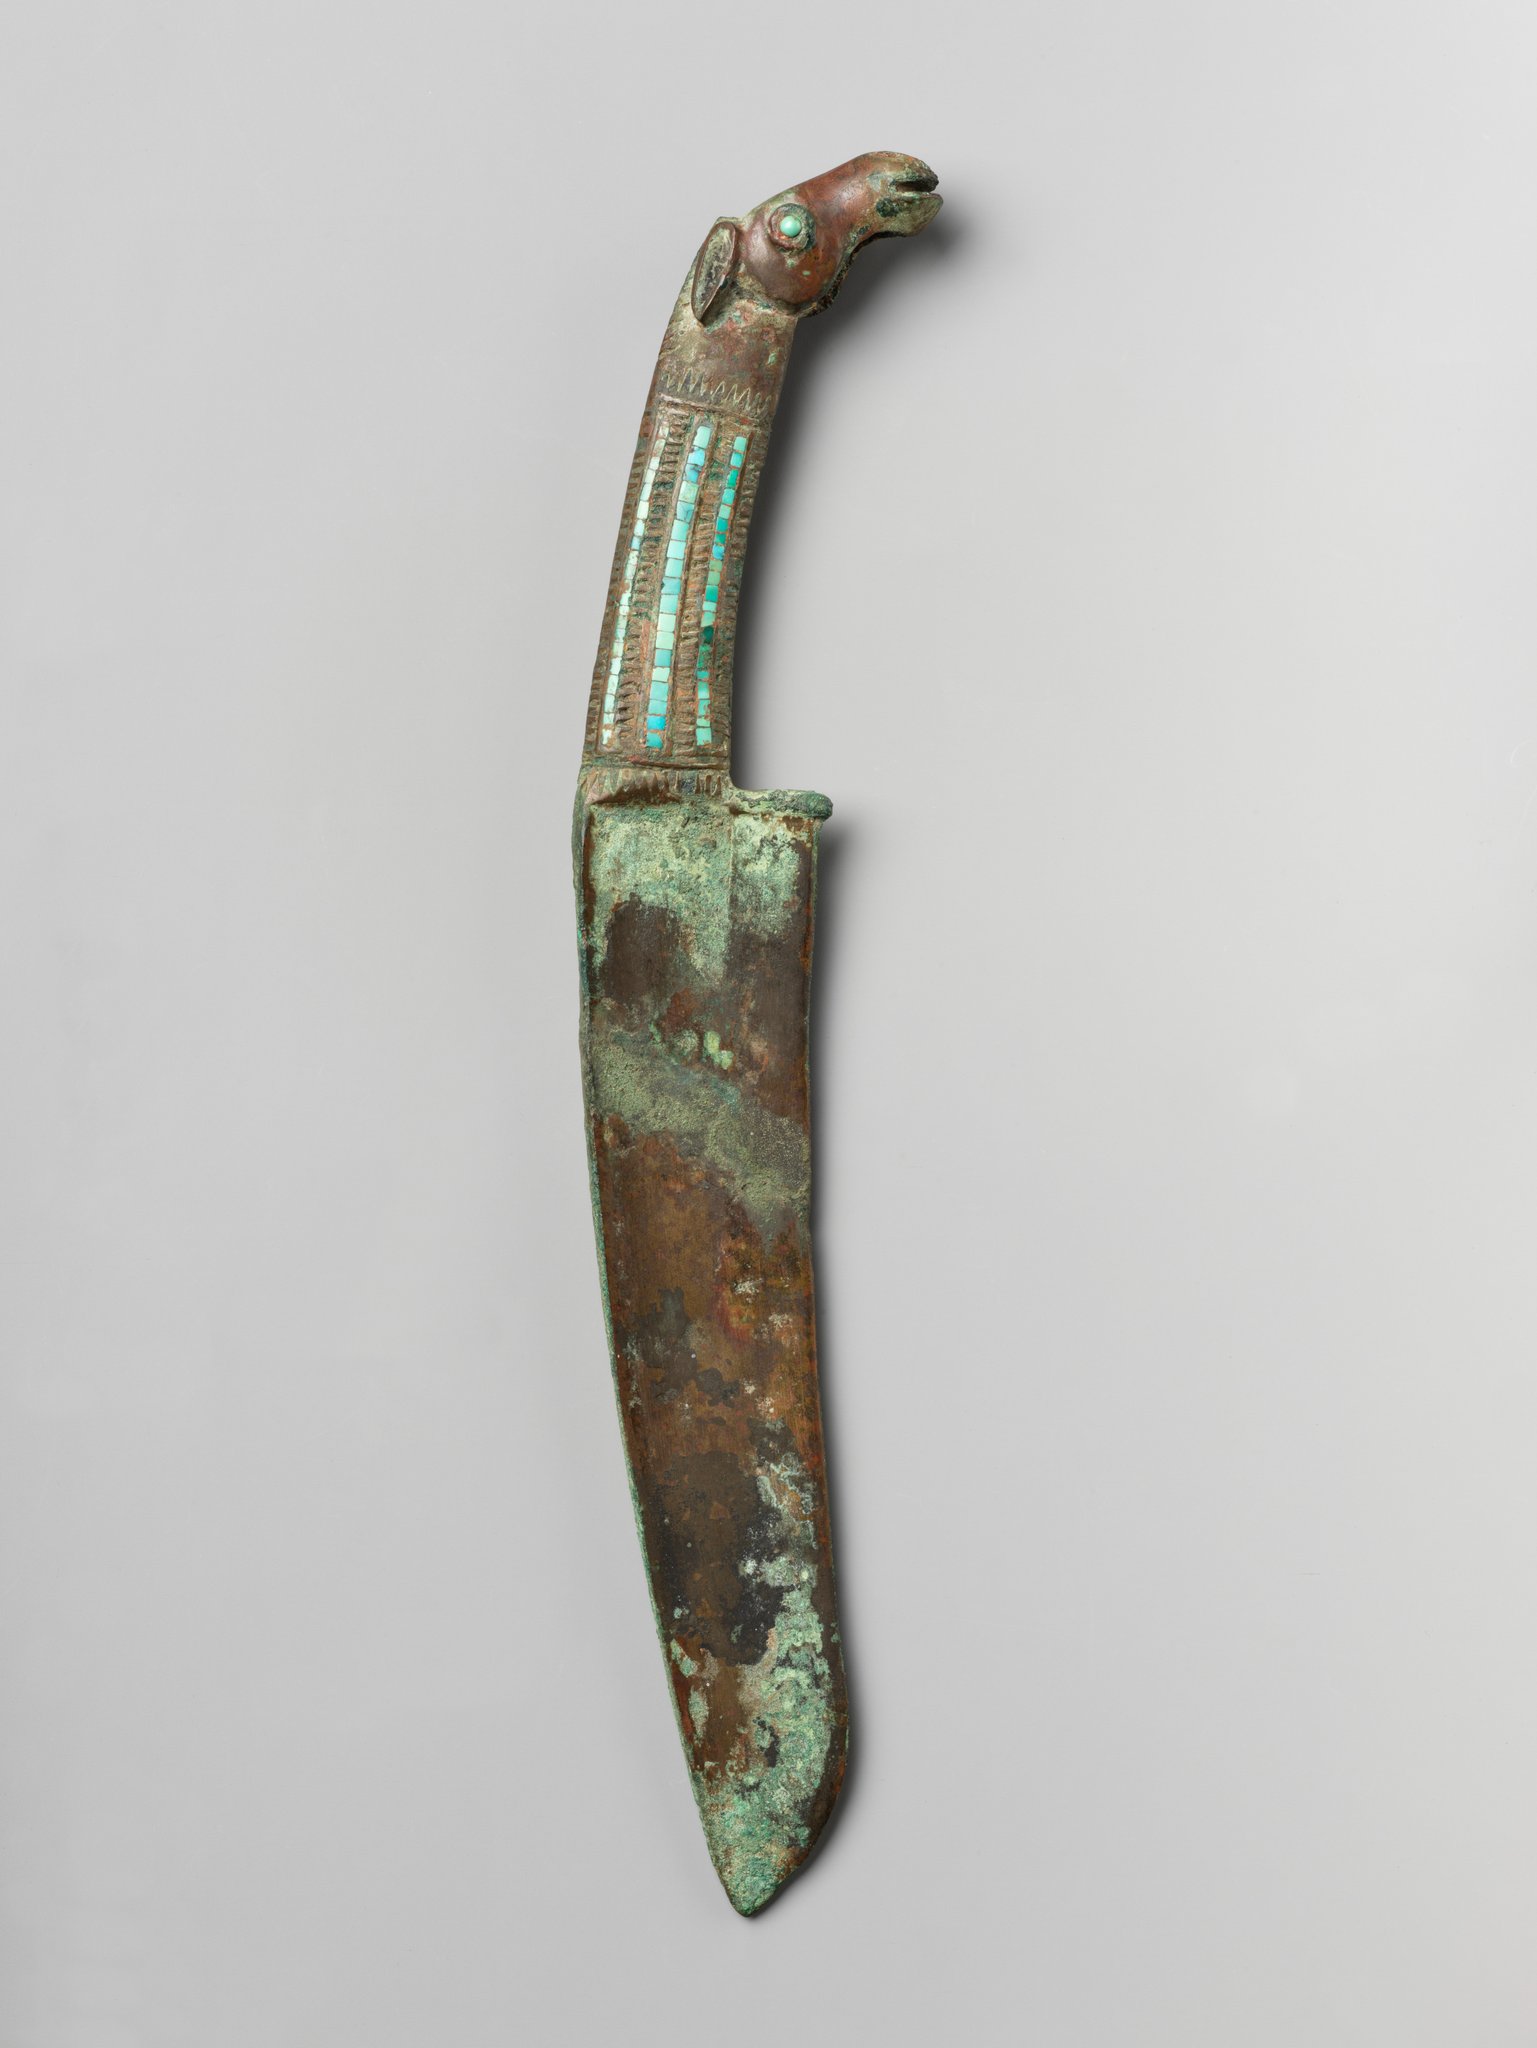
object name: knife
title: Animal-Head Knife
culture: chinese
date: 1100-1001 BCE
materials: bronze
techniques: inlay